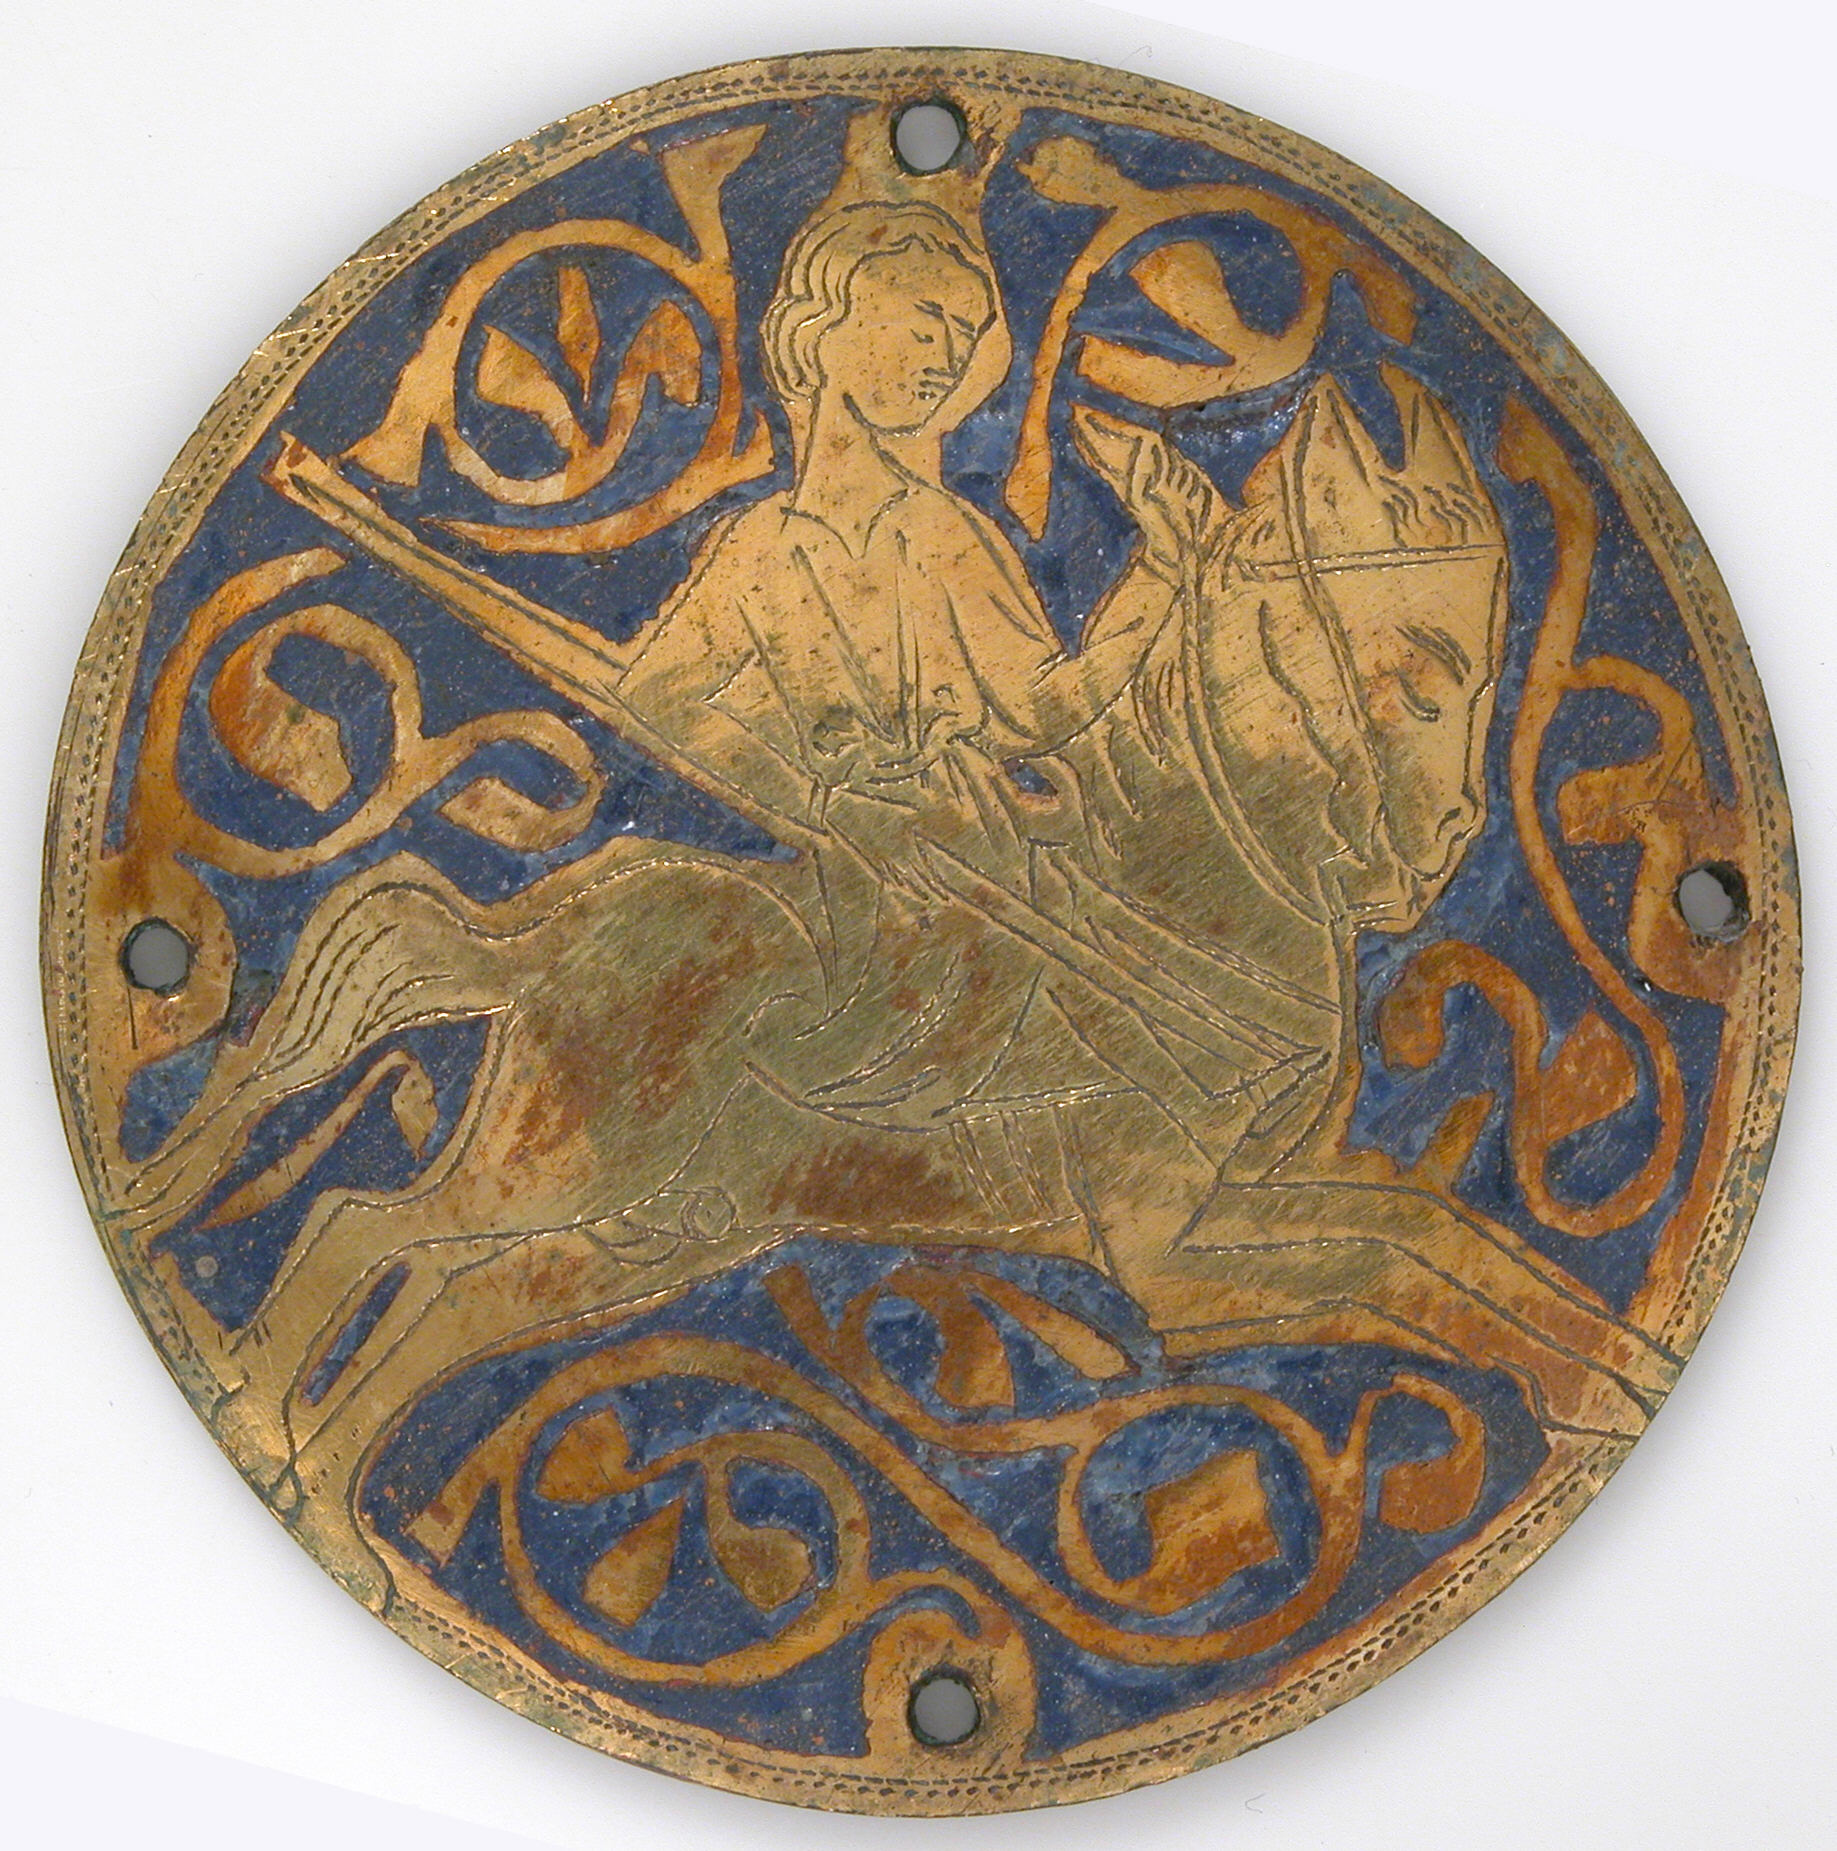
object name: medallion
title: Medallion with Youth on Galloping Horse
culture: french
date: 1240-1260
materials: copper, enamel, gilt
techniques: enamel, engraving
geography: france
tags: men,horses